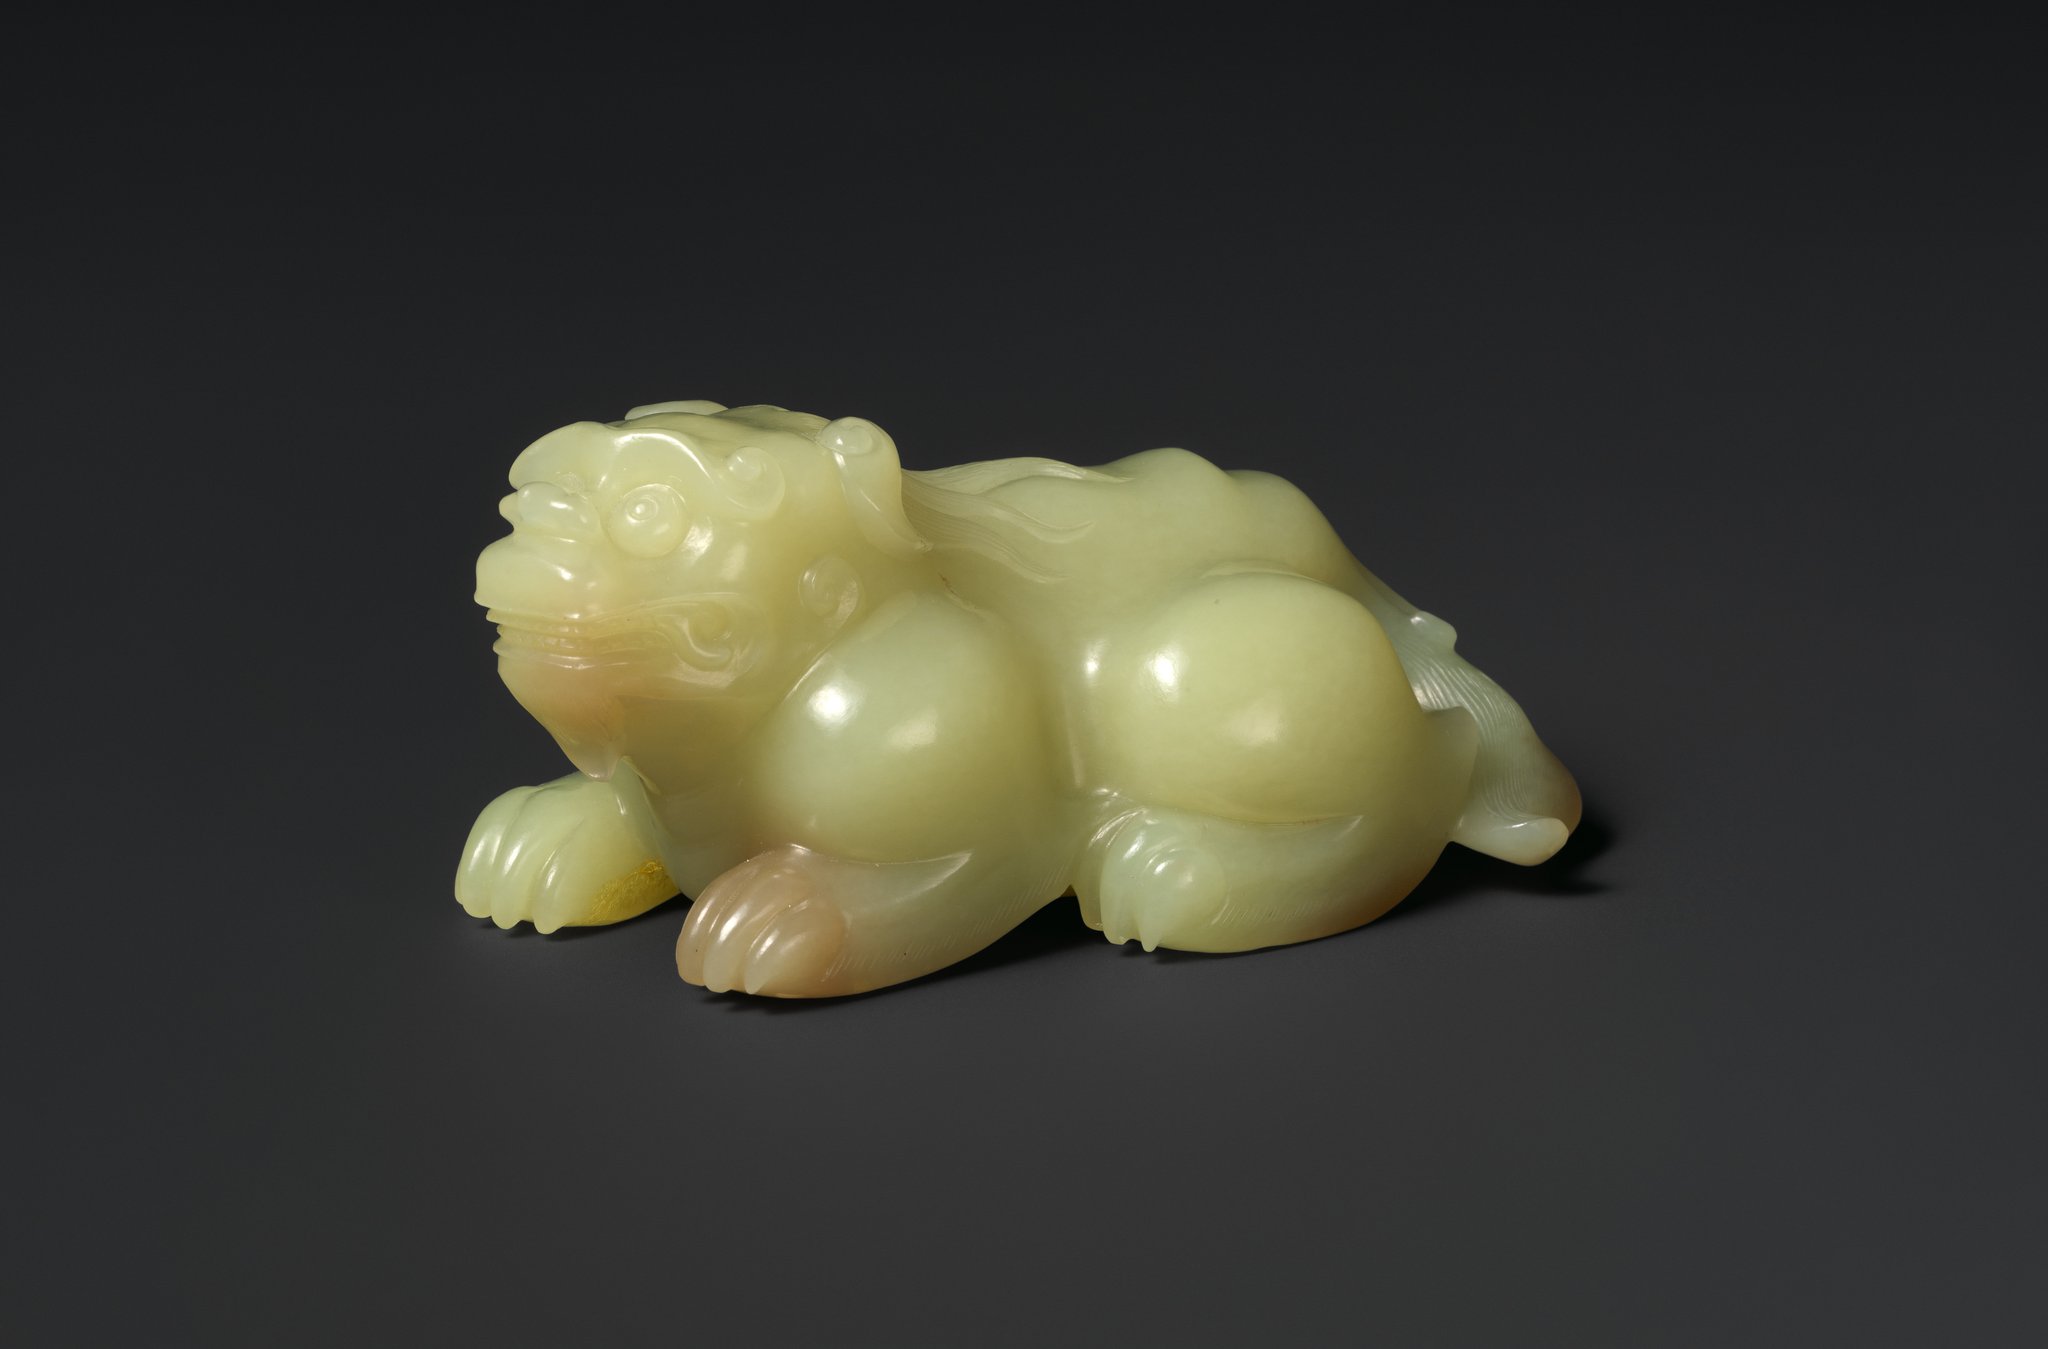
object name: figurine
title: Mythical animal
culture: chinese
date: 1701-1800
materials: jade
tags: mythical creatures